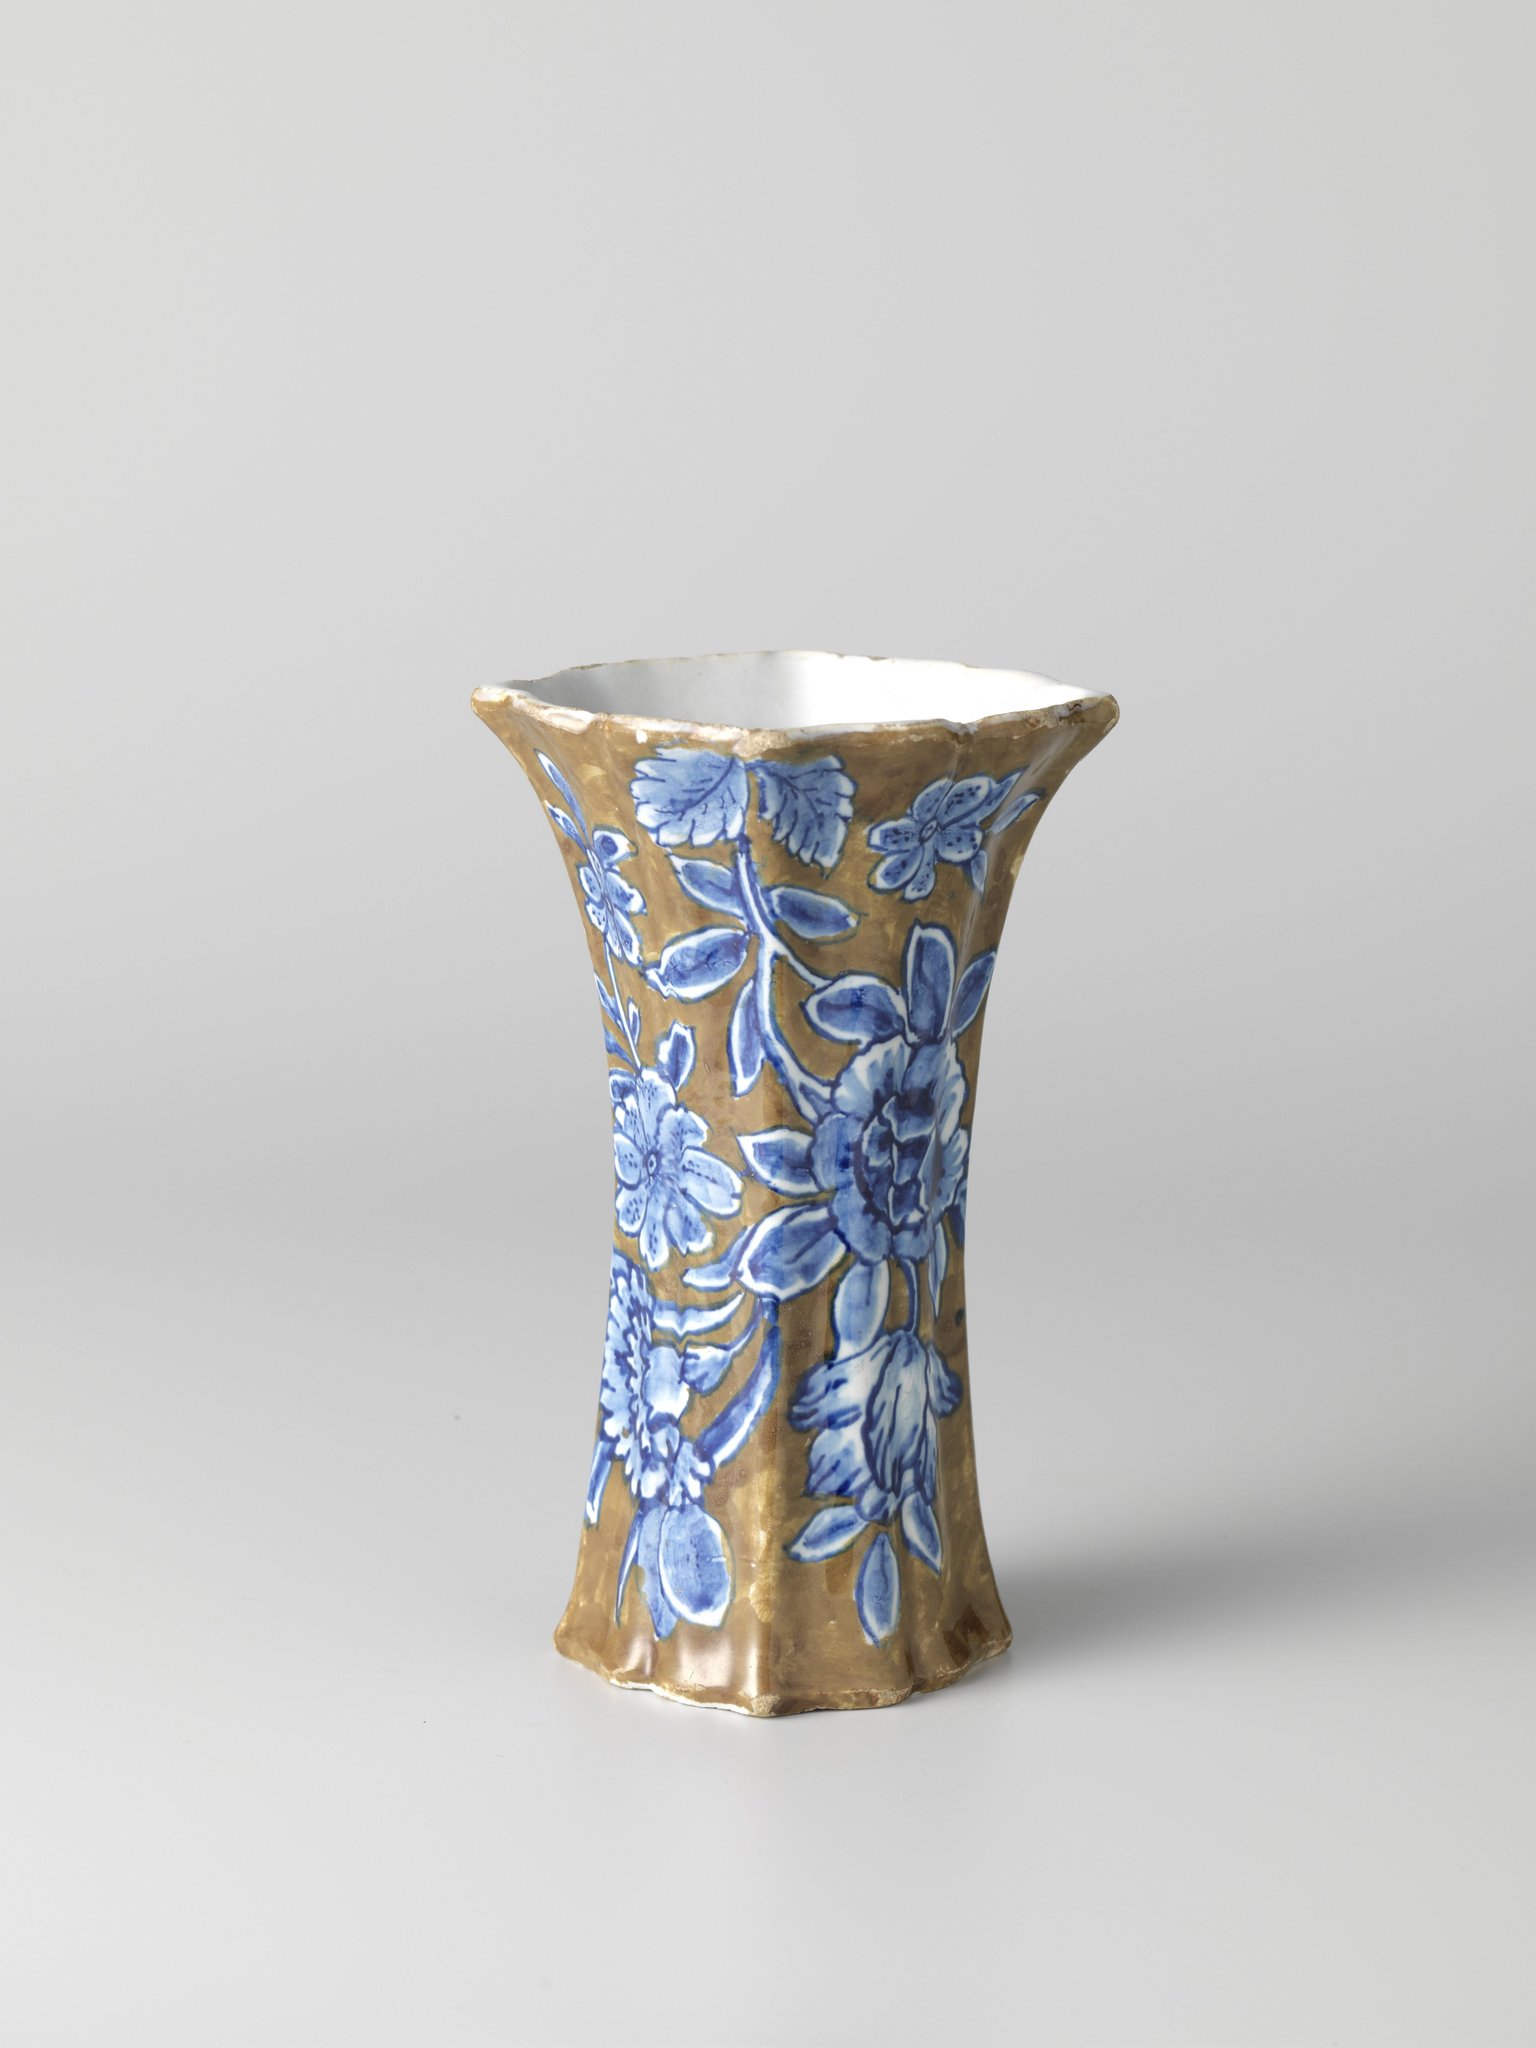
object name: vase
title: Vaas van faience met bloemen gedecoreerd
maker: Anonymous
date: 1740-1770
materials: faience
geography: delft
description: Vaas van faience. Veelkleurig beschilderd met bloemen.